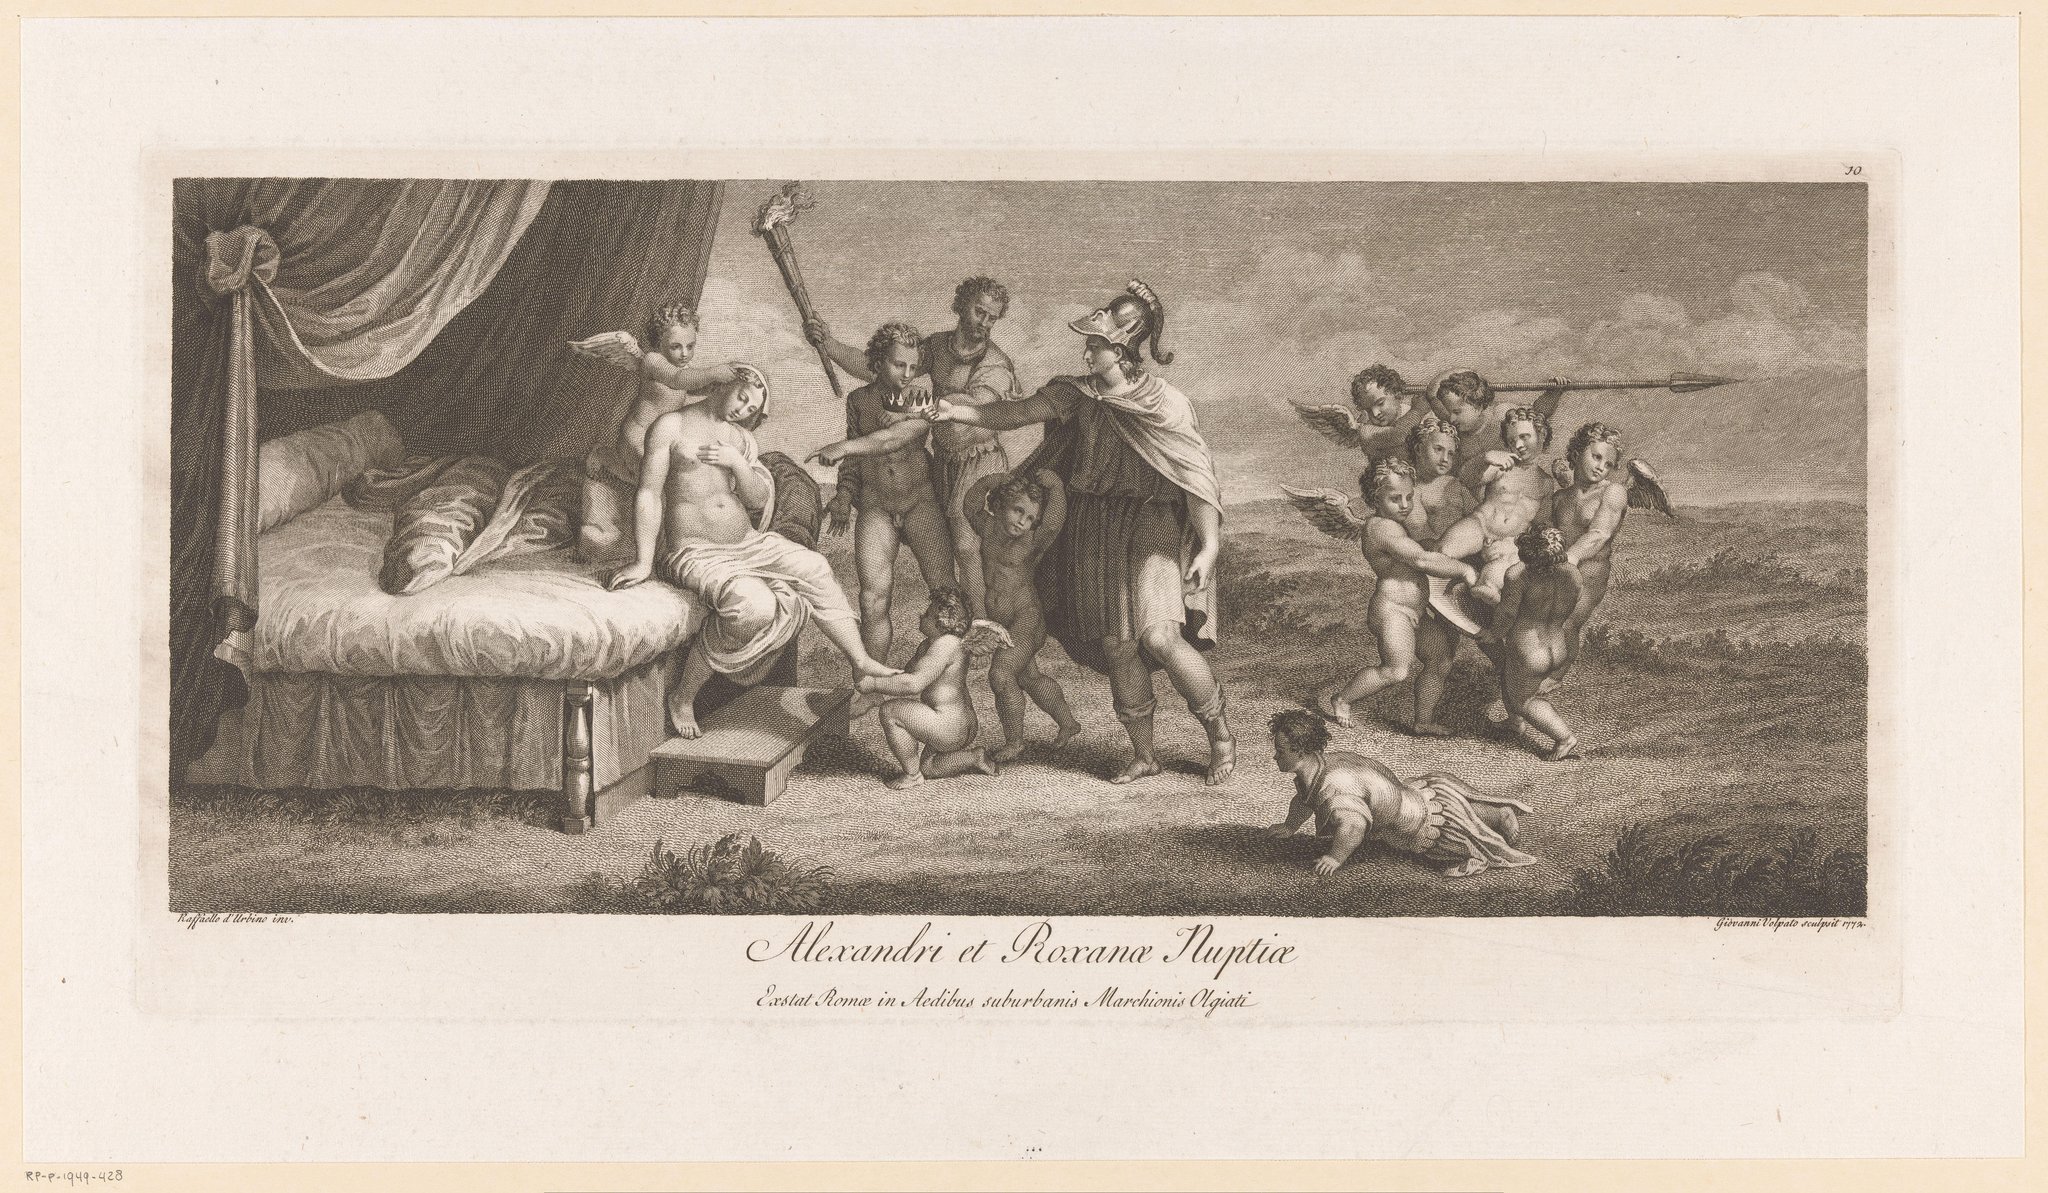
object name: print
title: Alexandri et Roxanae Nuptiae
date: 1772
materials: paper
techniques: etching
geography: italy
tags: marriage of alexander and roxana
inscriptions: collector's mark: Lugt 2228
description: De bruiloft van Alexander de Grote en Roxana. Alexander geeft een kroon aan Roxana, die op een bank onder een baldakijn zit. De naakte efebe Hymenaeus, de god van het huwelijk, wijst op Roxana en zal het paar in de echt verbinden. Alexanders gezel Hephaestion staat achter Hymenaeus en houdt een toorts vast. Rechts spelen putti met pijlen en een schild. Op de voorgrond heeft een putto een te groot borstkuras aangetrokken. Genummerd rechtsboven: 10. Titel in ondermarge.